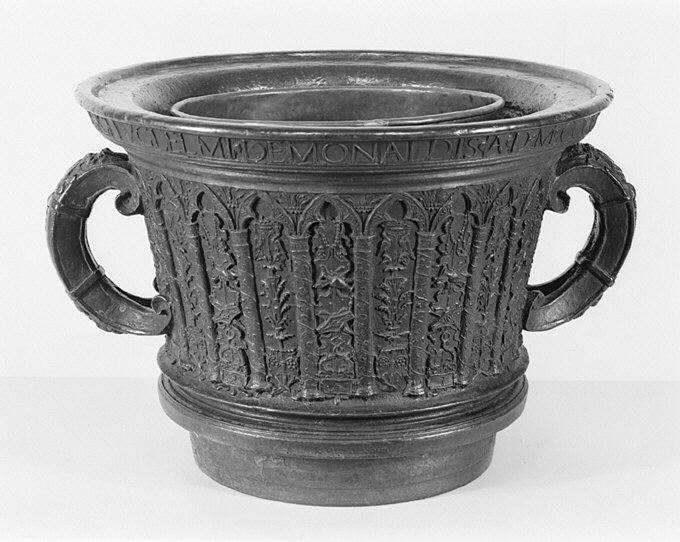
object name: mortar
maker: guglielmo de monaldis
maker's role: artist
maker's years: 1452-1552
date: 1502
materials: bronze